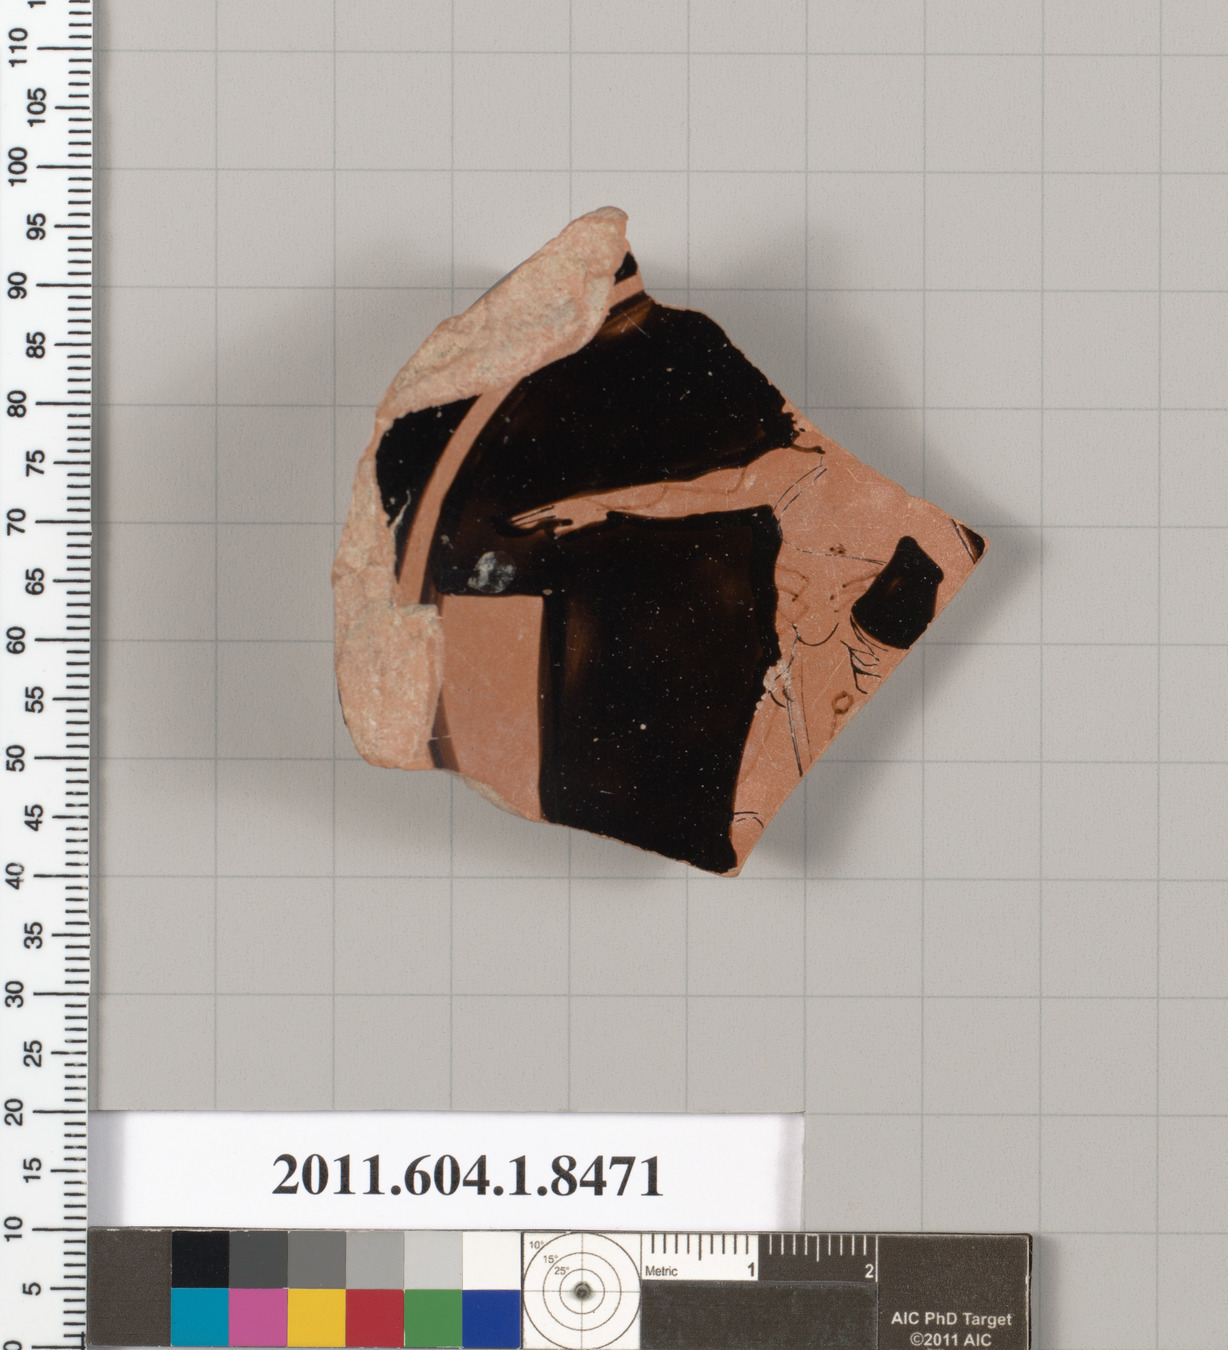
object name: kylix fragment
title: Terracotta fragment of a stemless kylix (drinking cup)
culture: greek, attic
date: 460-450 BCE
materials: terracotta